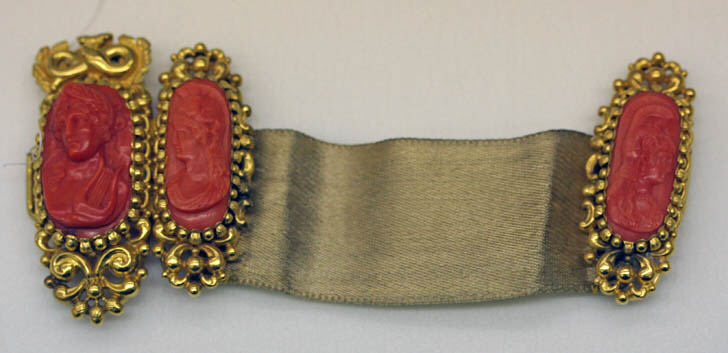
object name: bracelet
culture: american or european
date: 1801-1833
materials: coral, gold, gold thread